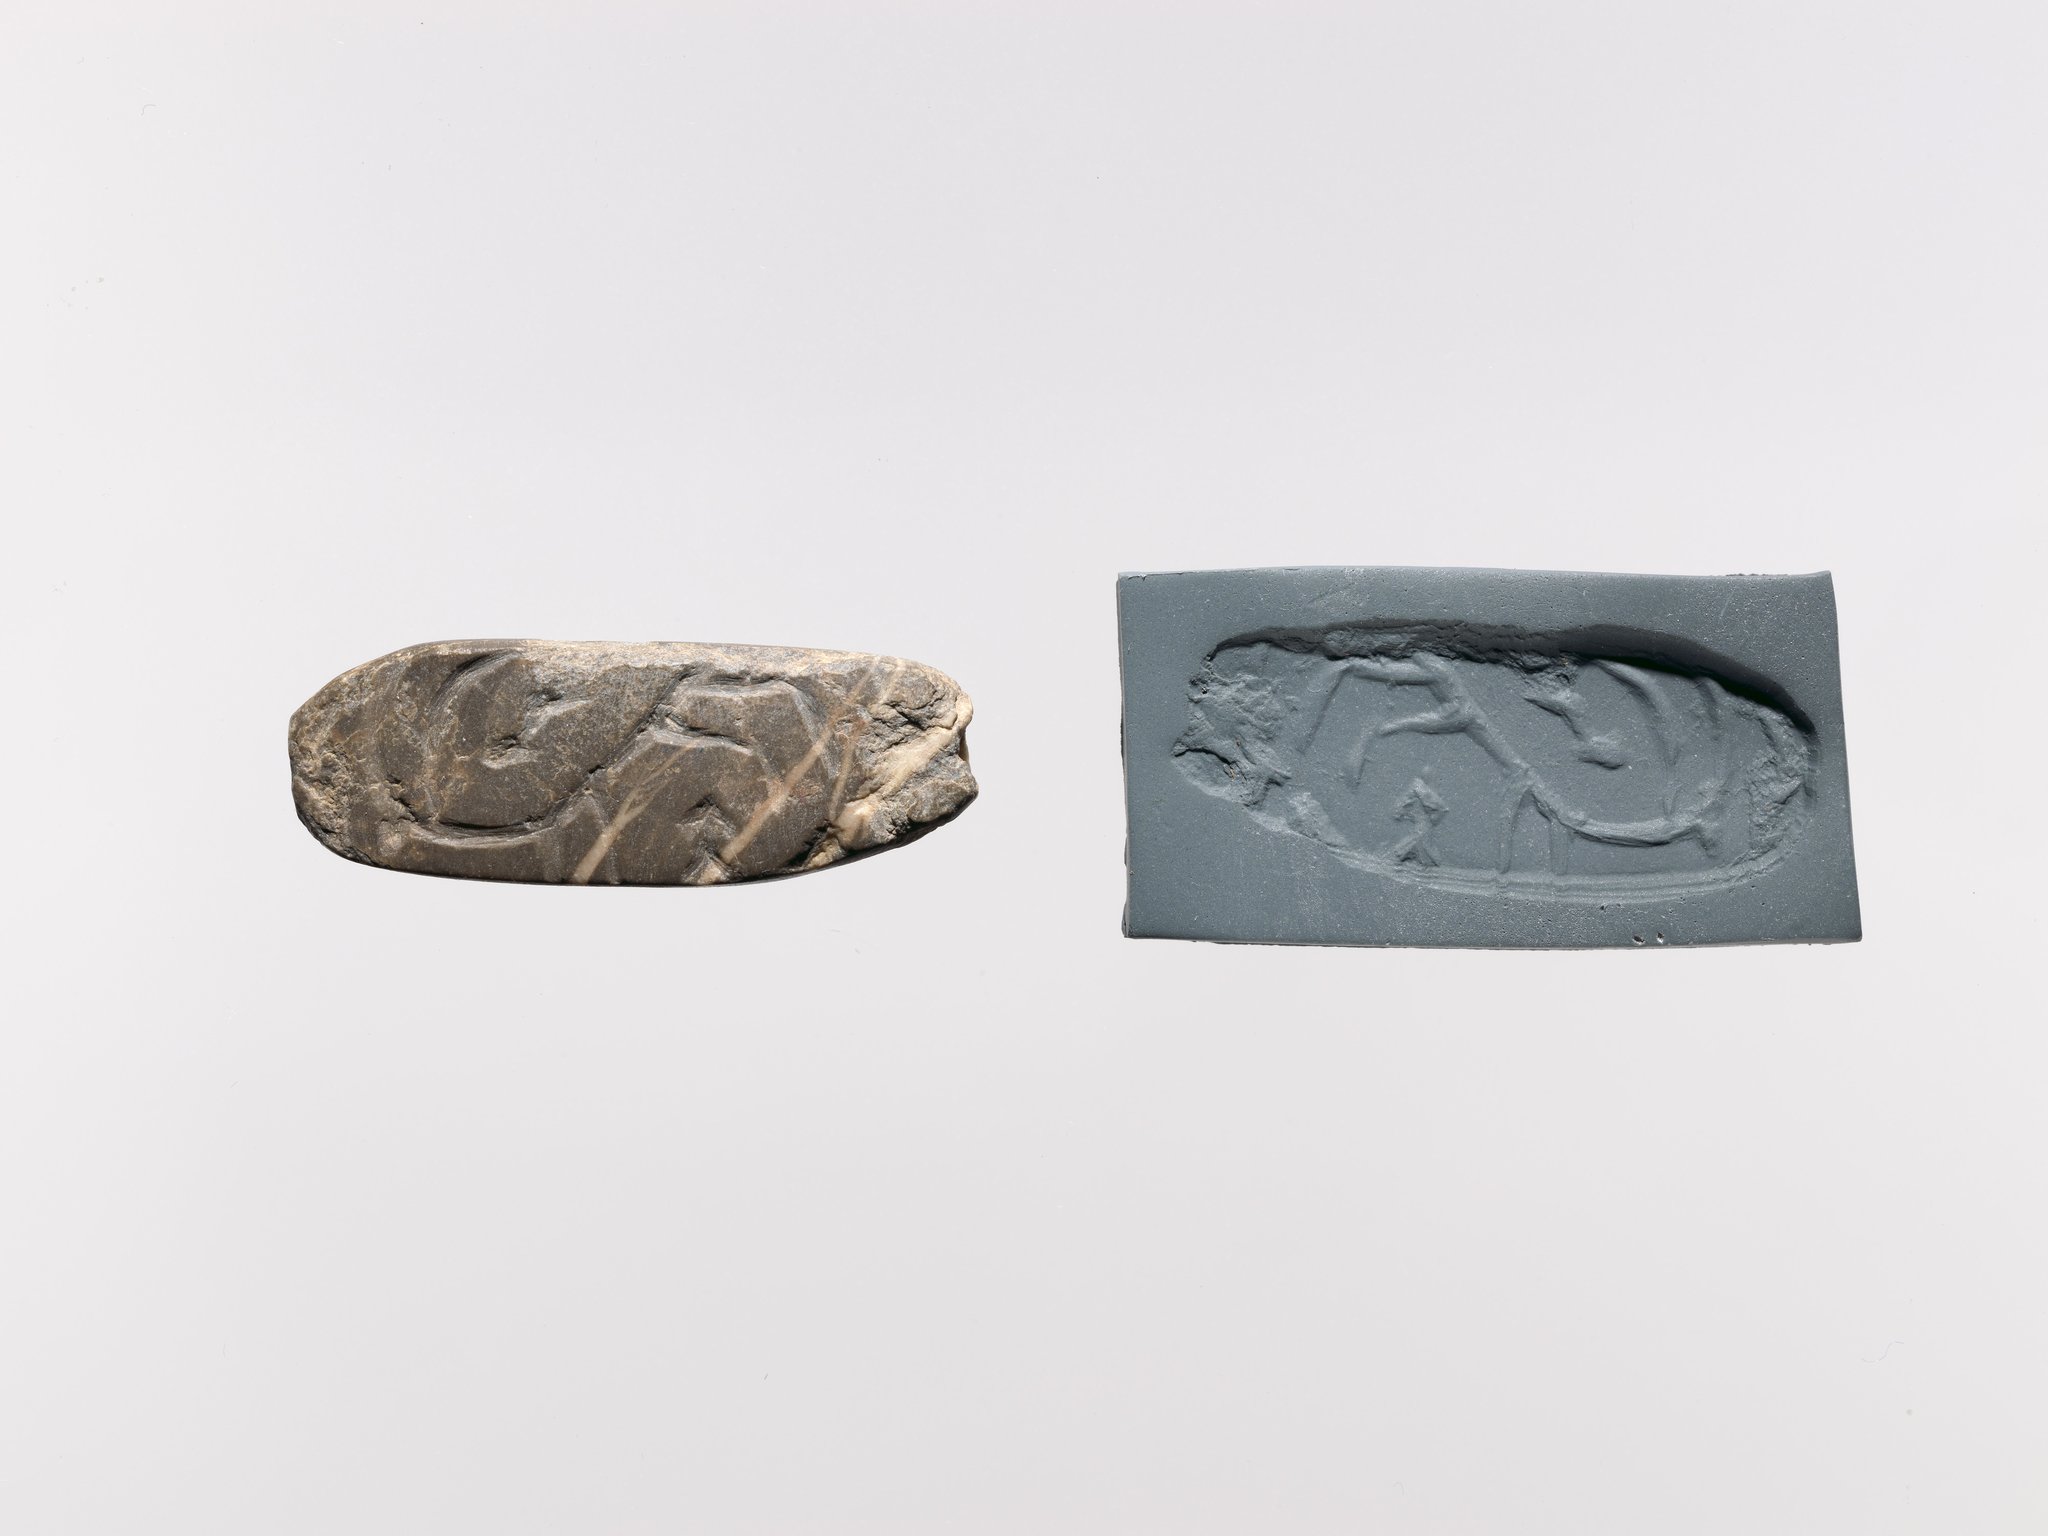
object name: stamp seal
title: Flattened pebble seal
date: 3500-2900 BCE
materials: stone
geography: mesopotamia